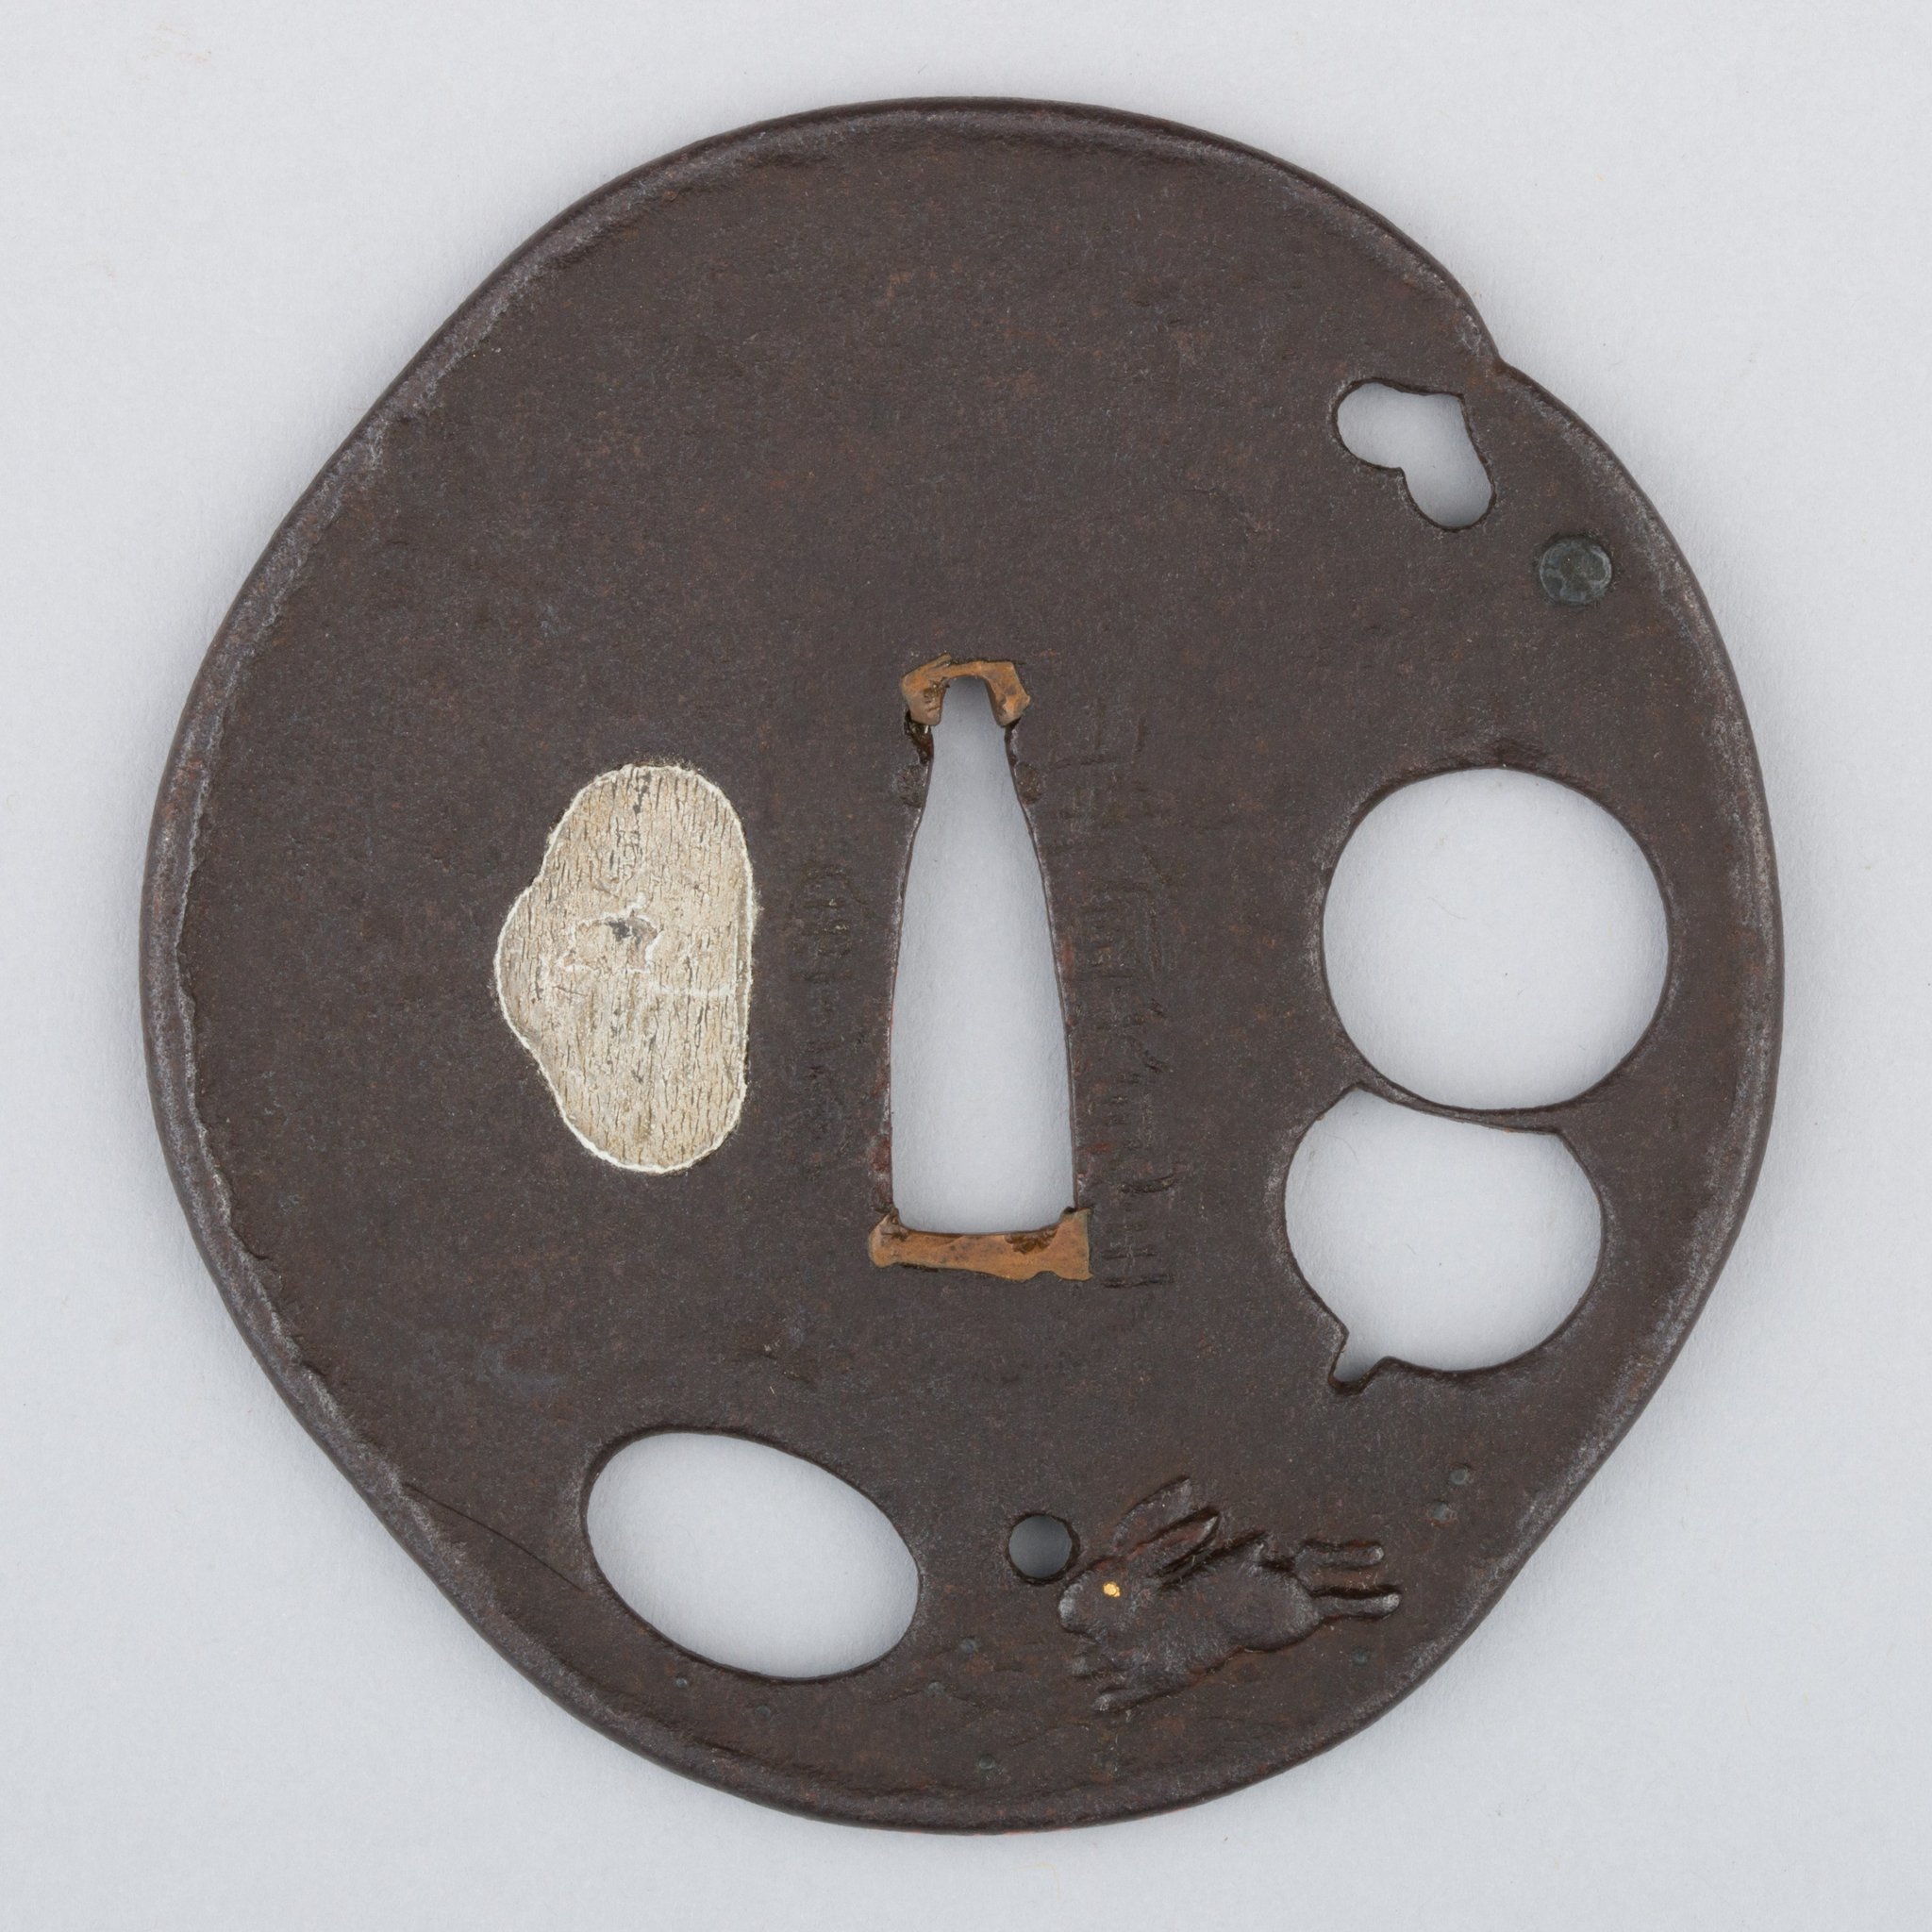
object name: sword guard tsuba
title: Sword Guard (Tsuba)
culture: japanese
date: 1615-1868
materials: copper, iron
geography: japan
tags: rabbits